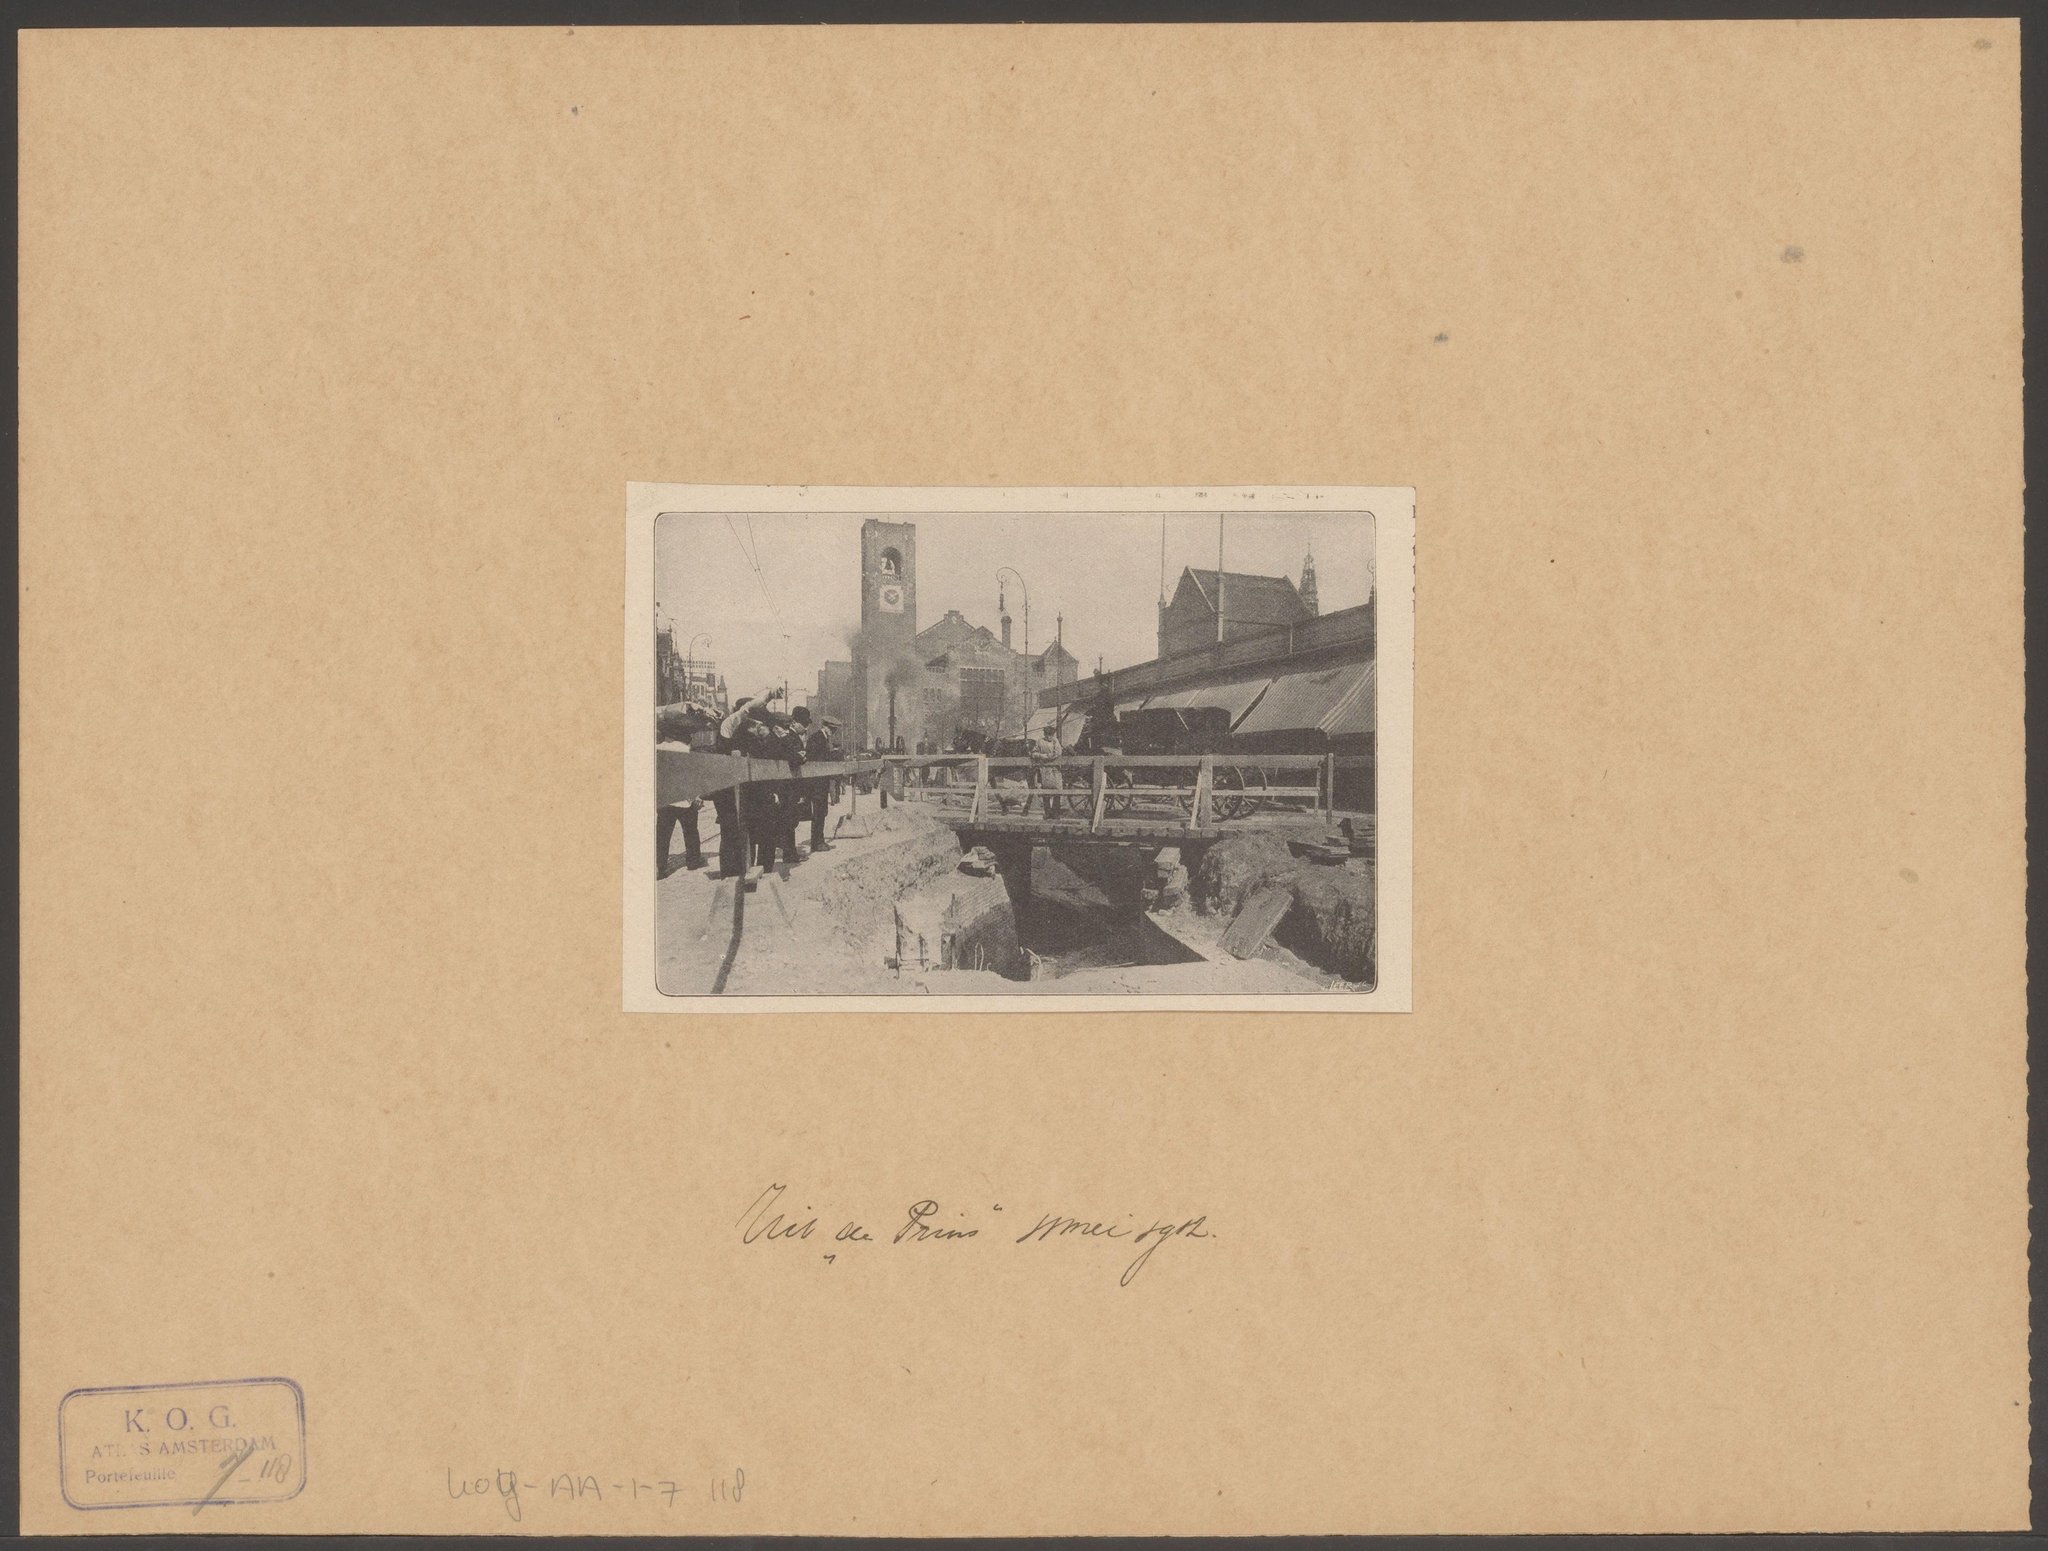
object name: photomechanical print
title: Gezicht op bouwwerkzaamheden voor de Beurs van Berlage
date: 1912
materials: paper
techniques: letterpress printing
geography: amsterdam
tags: city-view in general; 'veduta', building-site, street, market-hall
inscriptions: collector's mark: ‘7’ Lugt 1641b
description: Onderwerpsrubriek binnen de Atlas Amsterdam: Damrak, Damstraat, Doelensluis, Doelenstraat (Nieuwe), Driehoekstraat, Droogbak, Duvelshoek, Dijkstraat en Korte -.